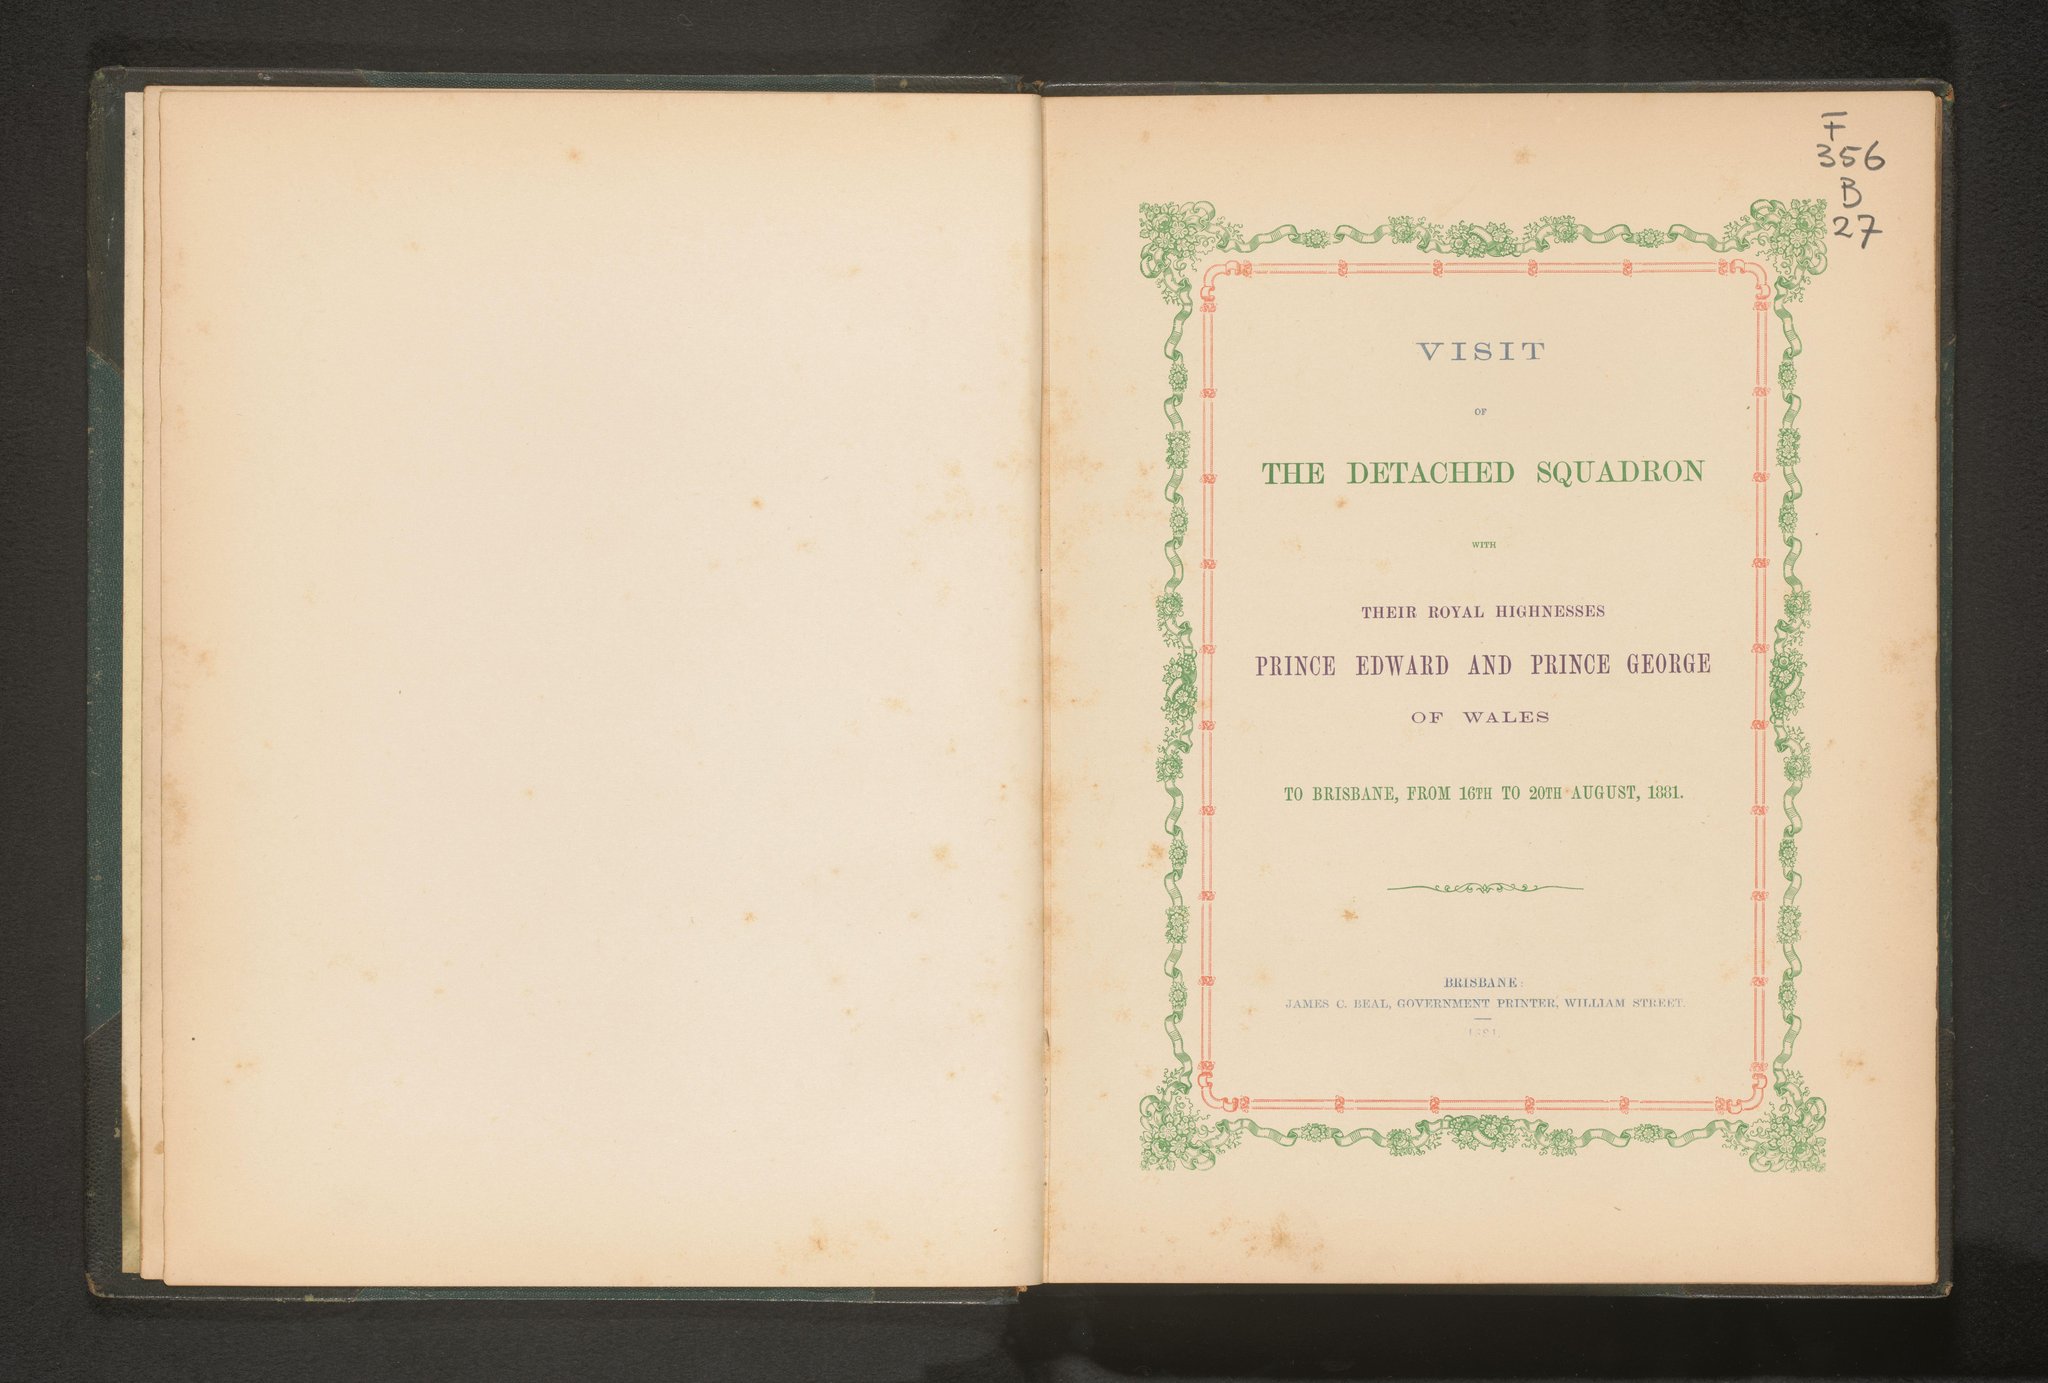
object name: book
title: Visit of the detached squadron with their Royal Highnesses Prince Edward and Prince George of Wales to Brisbane, from 16th to 20th August, 1881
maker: james c. beal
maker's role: printer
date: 1881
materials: cardboard, leather, paper, photographic support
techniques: albumen print, chromolithography, printing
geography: brisbane